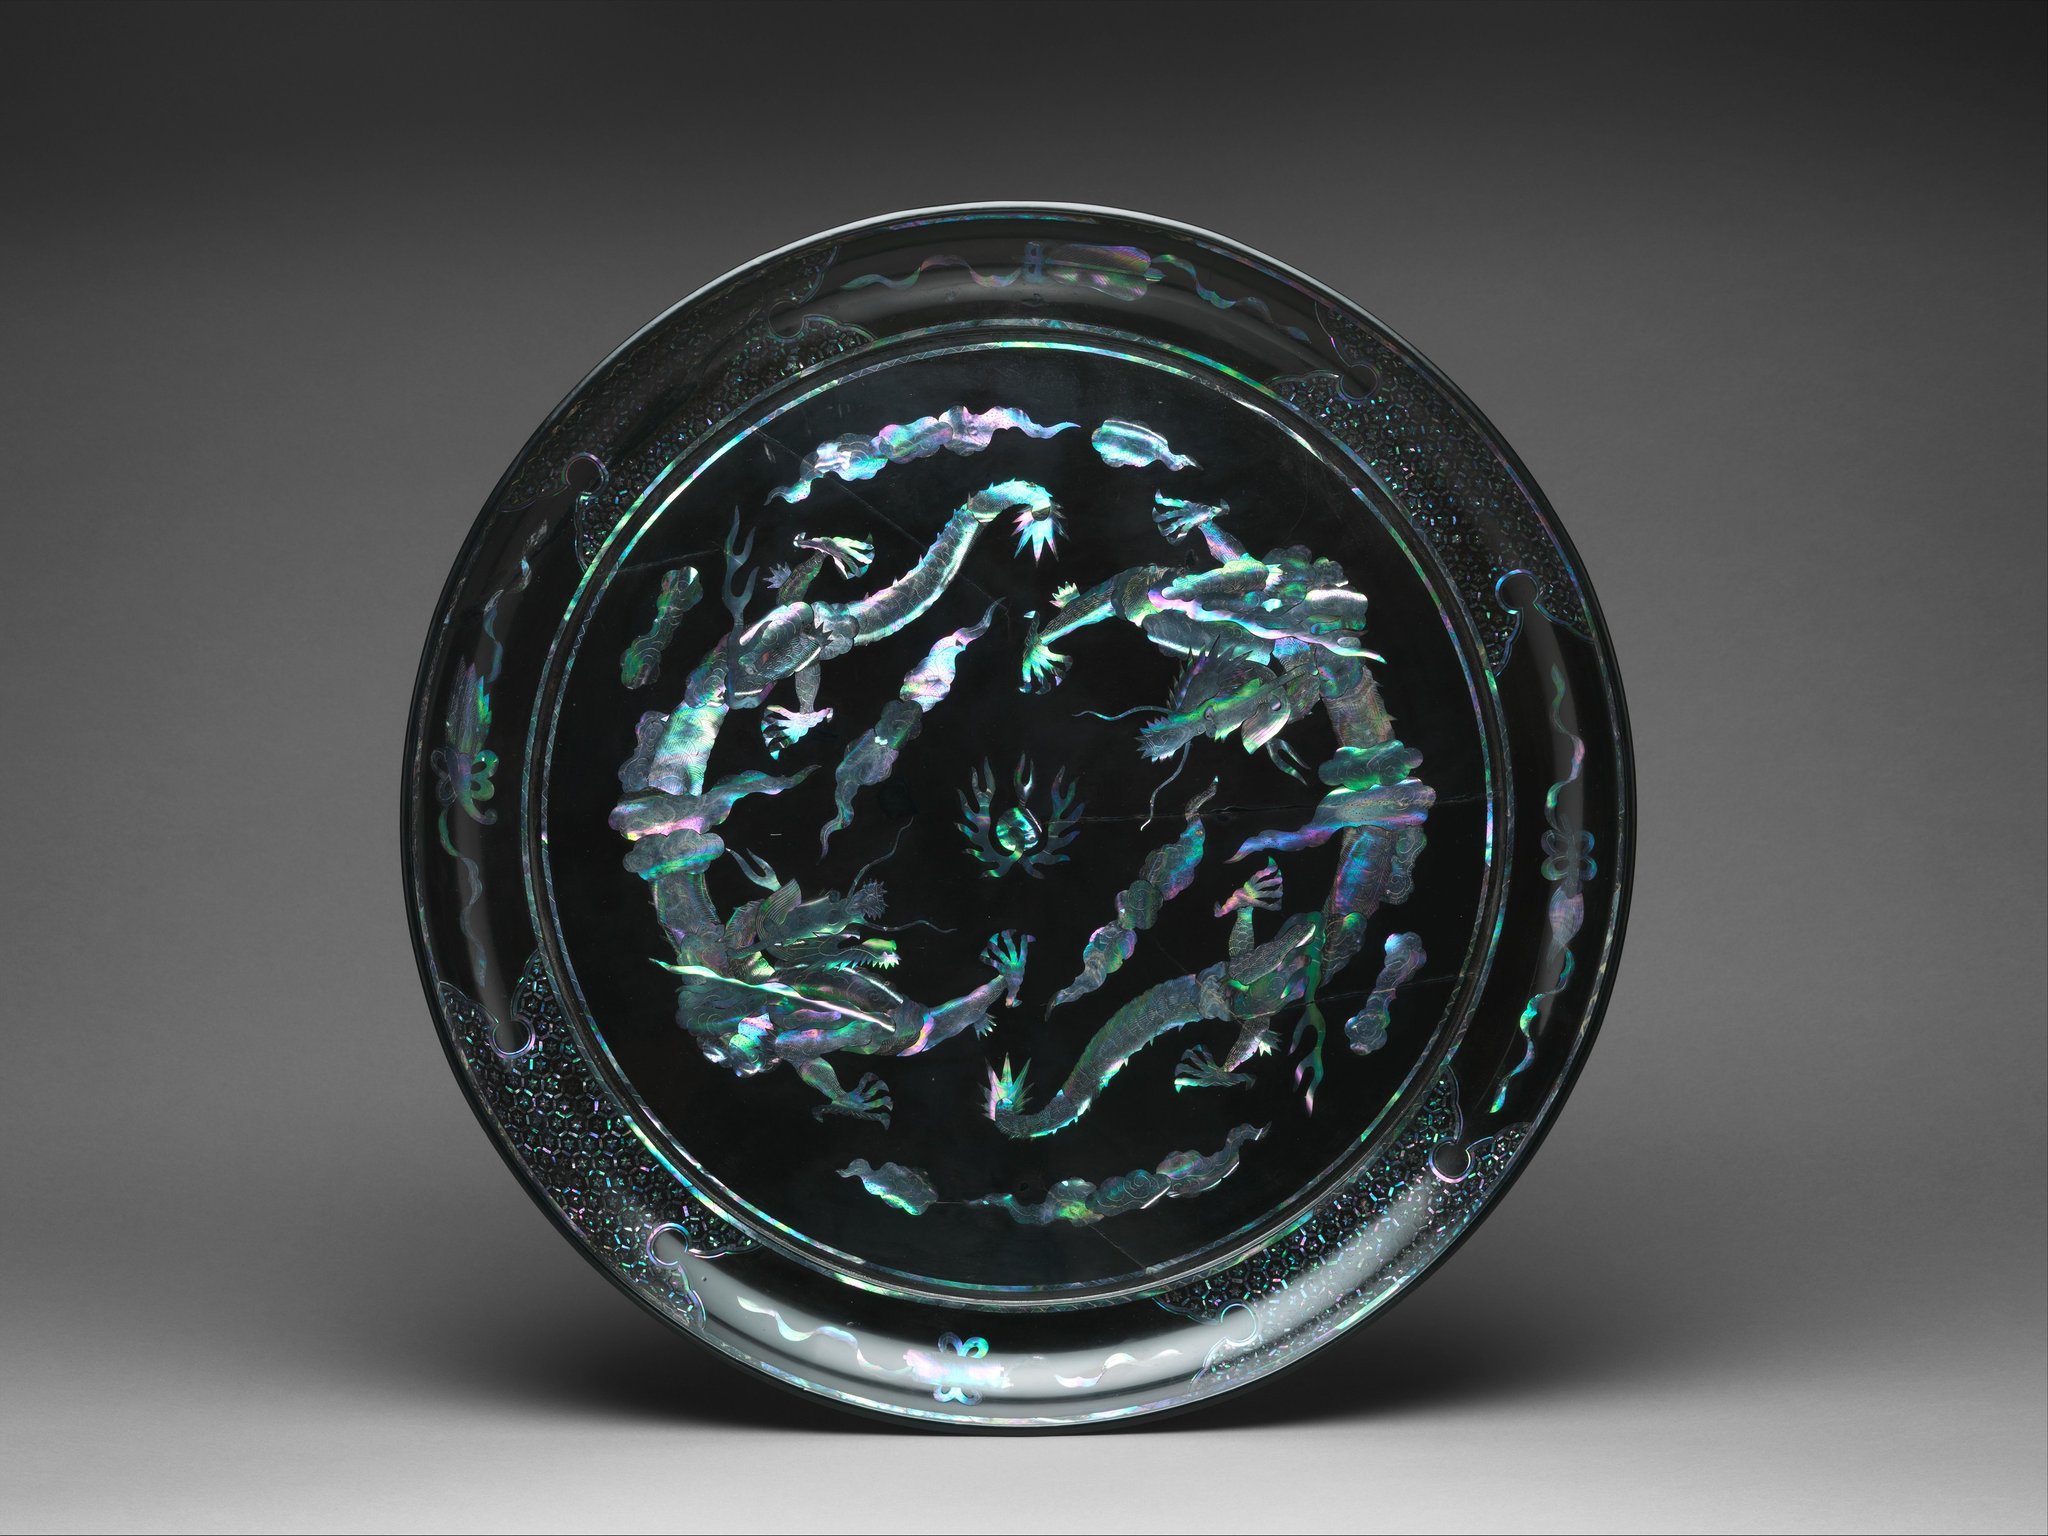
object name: tray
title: Tray with Pair of Dragons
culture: japanese or ryukyuan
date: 1701-1800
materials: lacquer, mother of pearl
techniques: inlay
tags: dragons